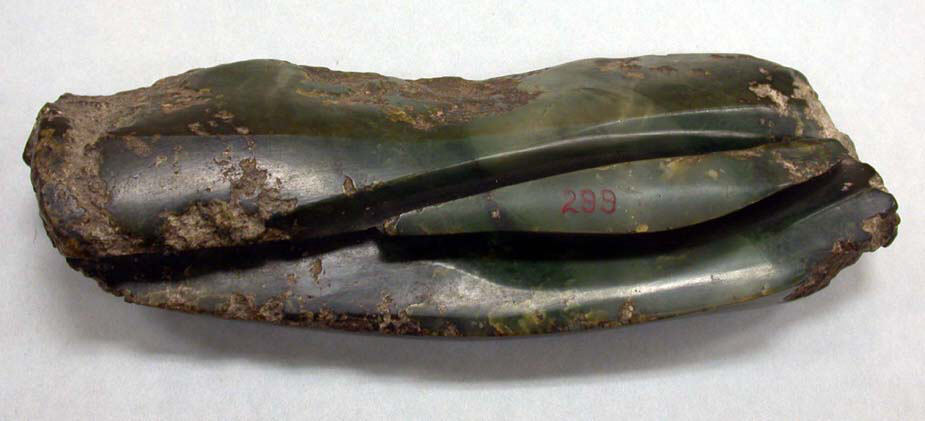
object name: piece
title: Partly Worked Piece of Jadeite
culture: new zealander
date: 1902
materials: jade